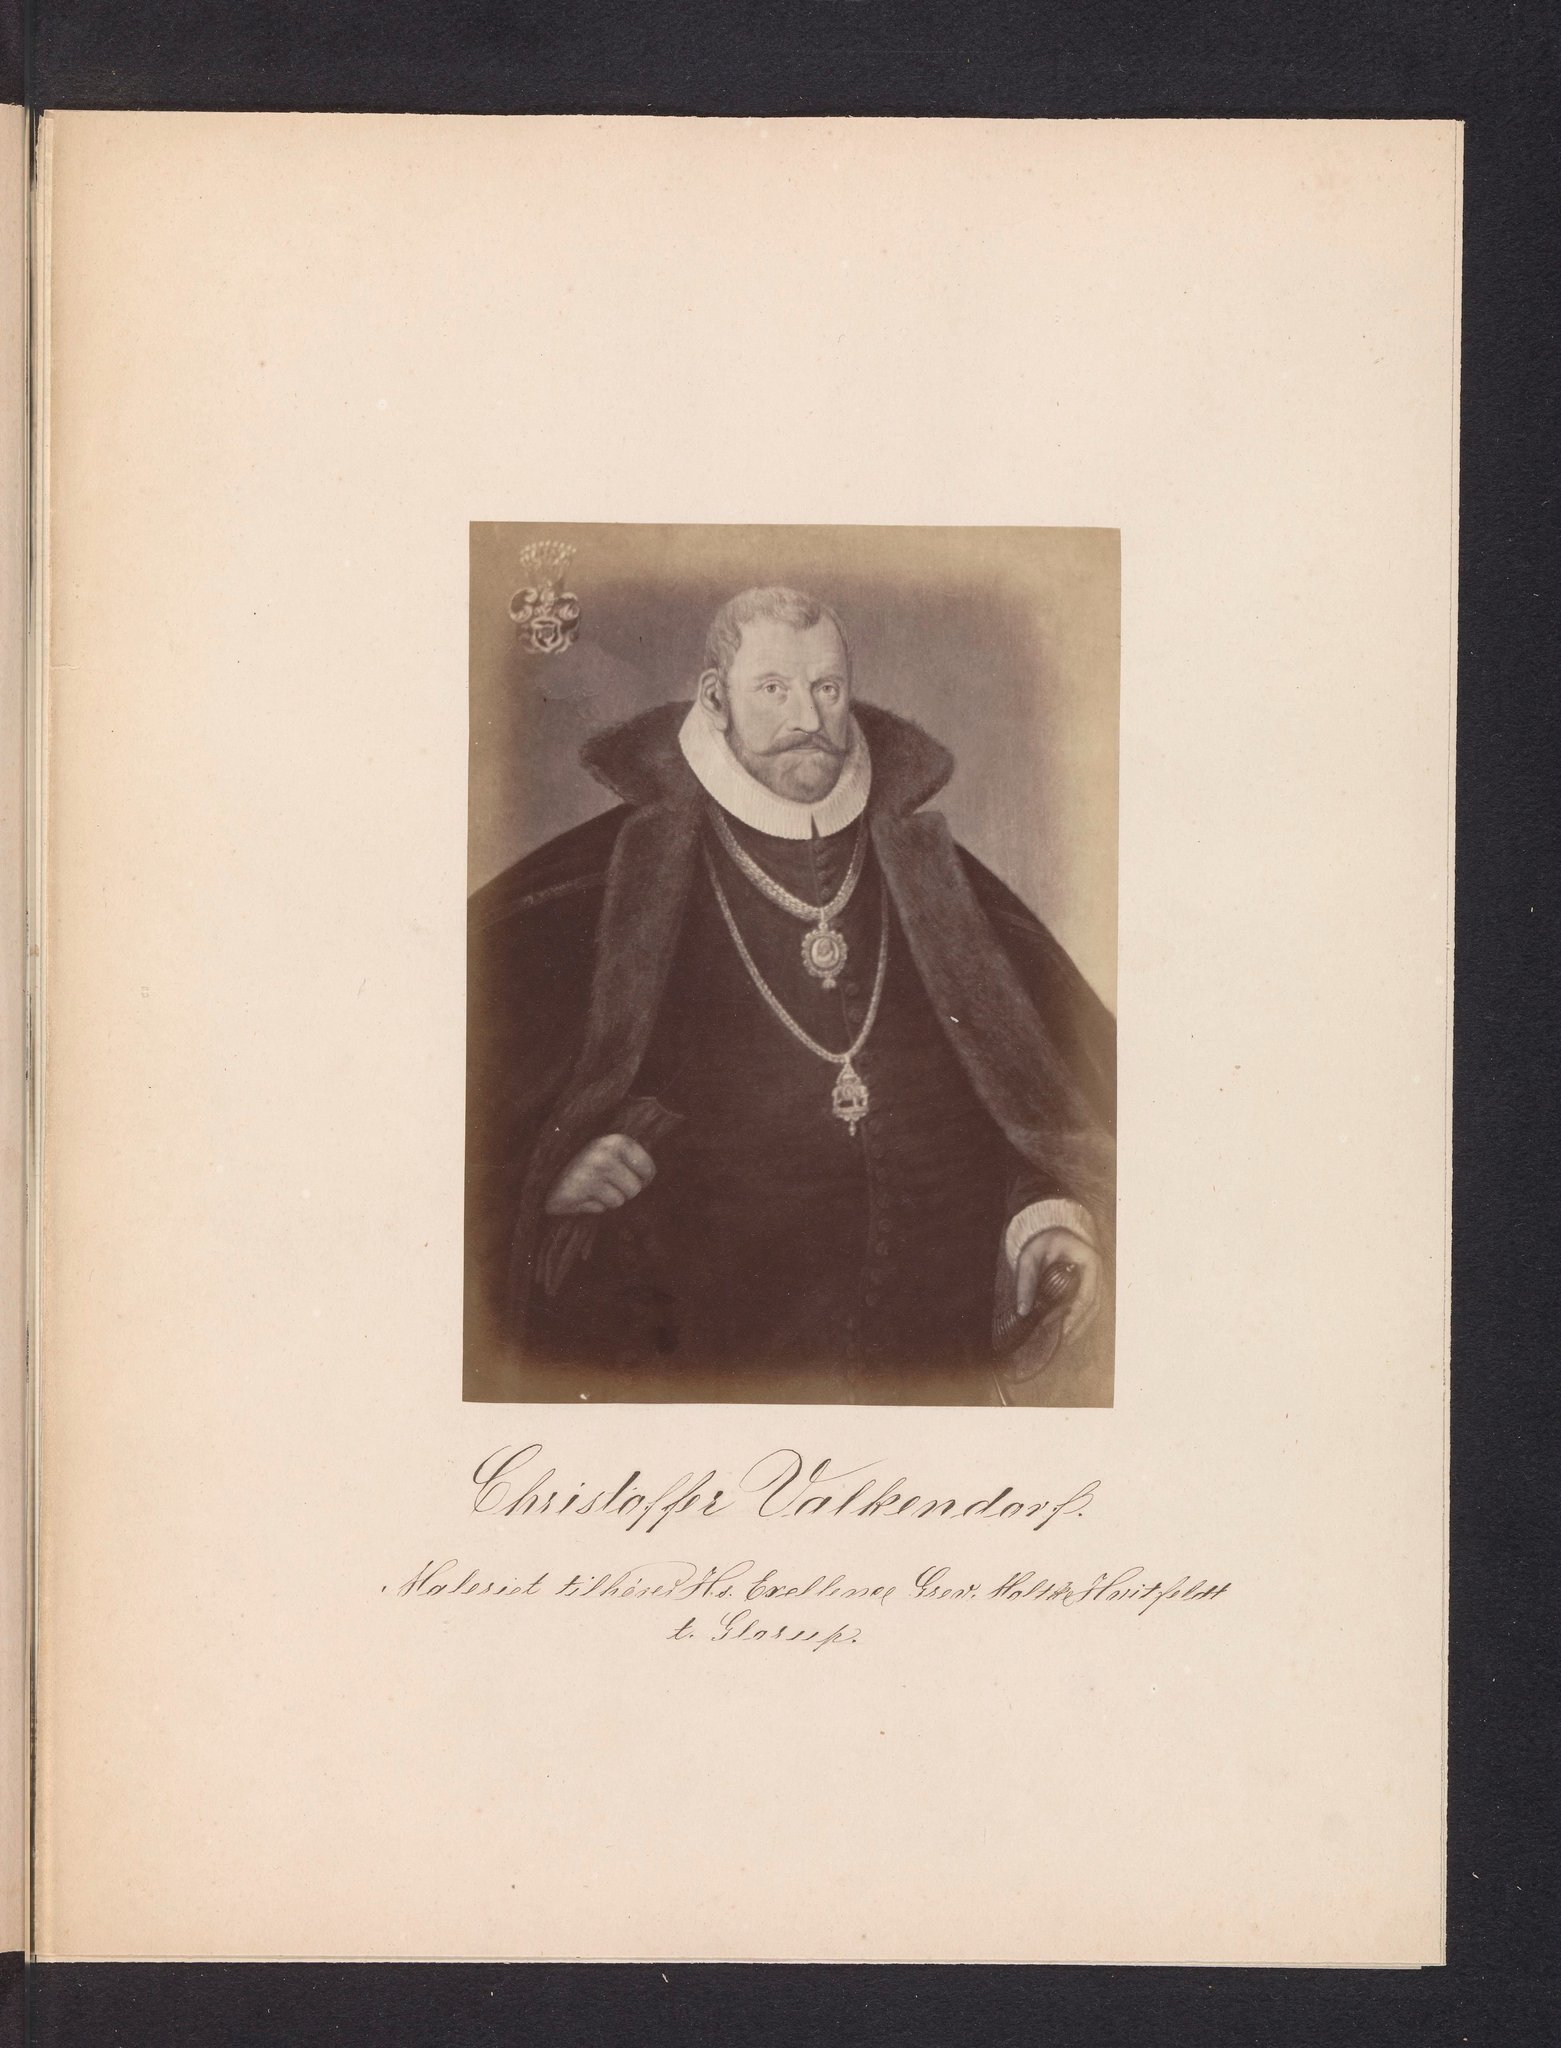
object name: page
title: Christoffer Valkendorf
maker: julius wulff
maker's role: fotograaf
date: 1858-1862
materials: photographic support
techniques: albumen print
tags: official; civil servant; functionary (in general)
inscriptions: inscription: ‘Maleriet tillhører Hs. Exellence Grev Moltke Hvitfeldt til Glorup.’